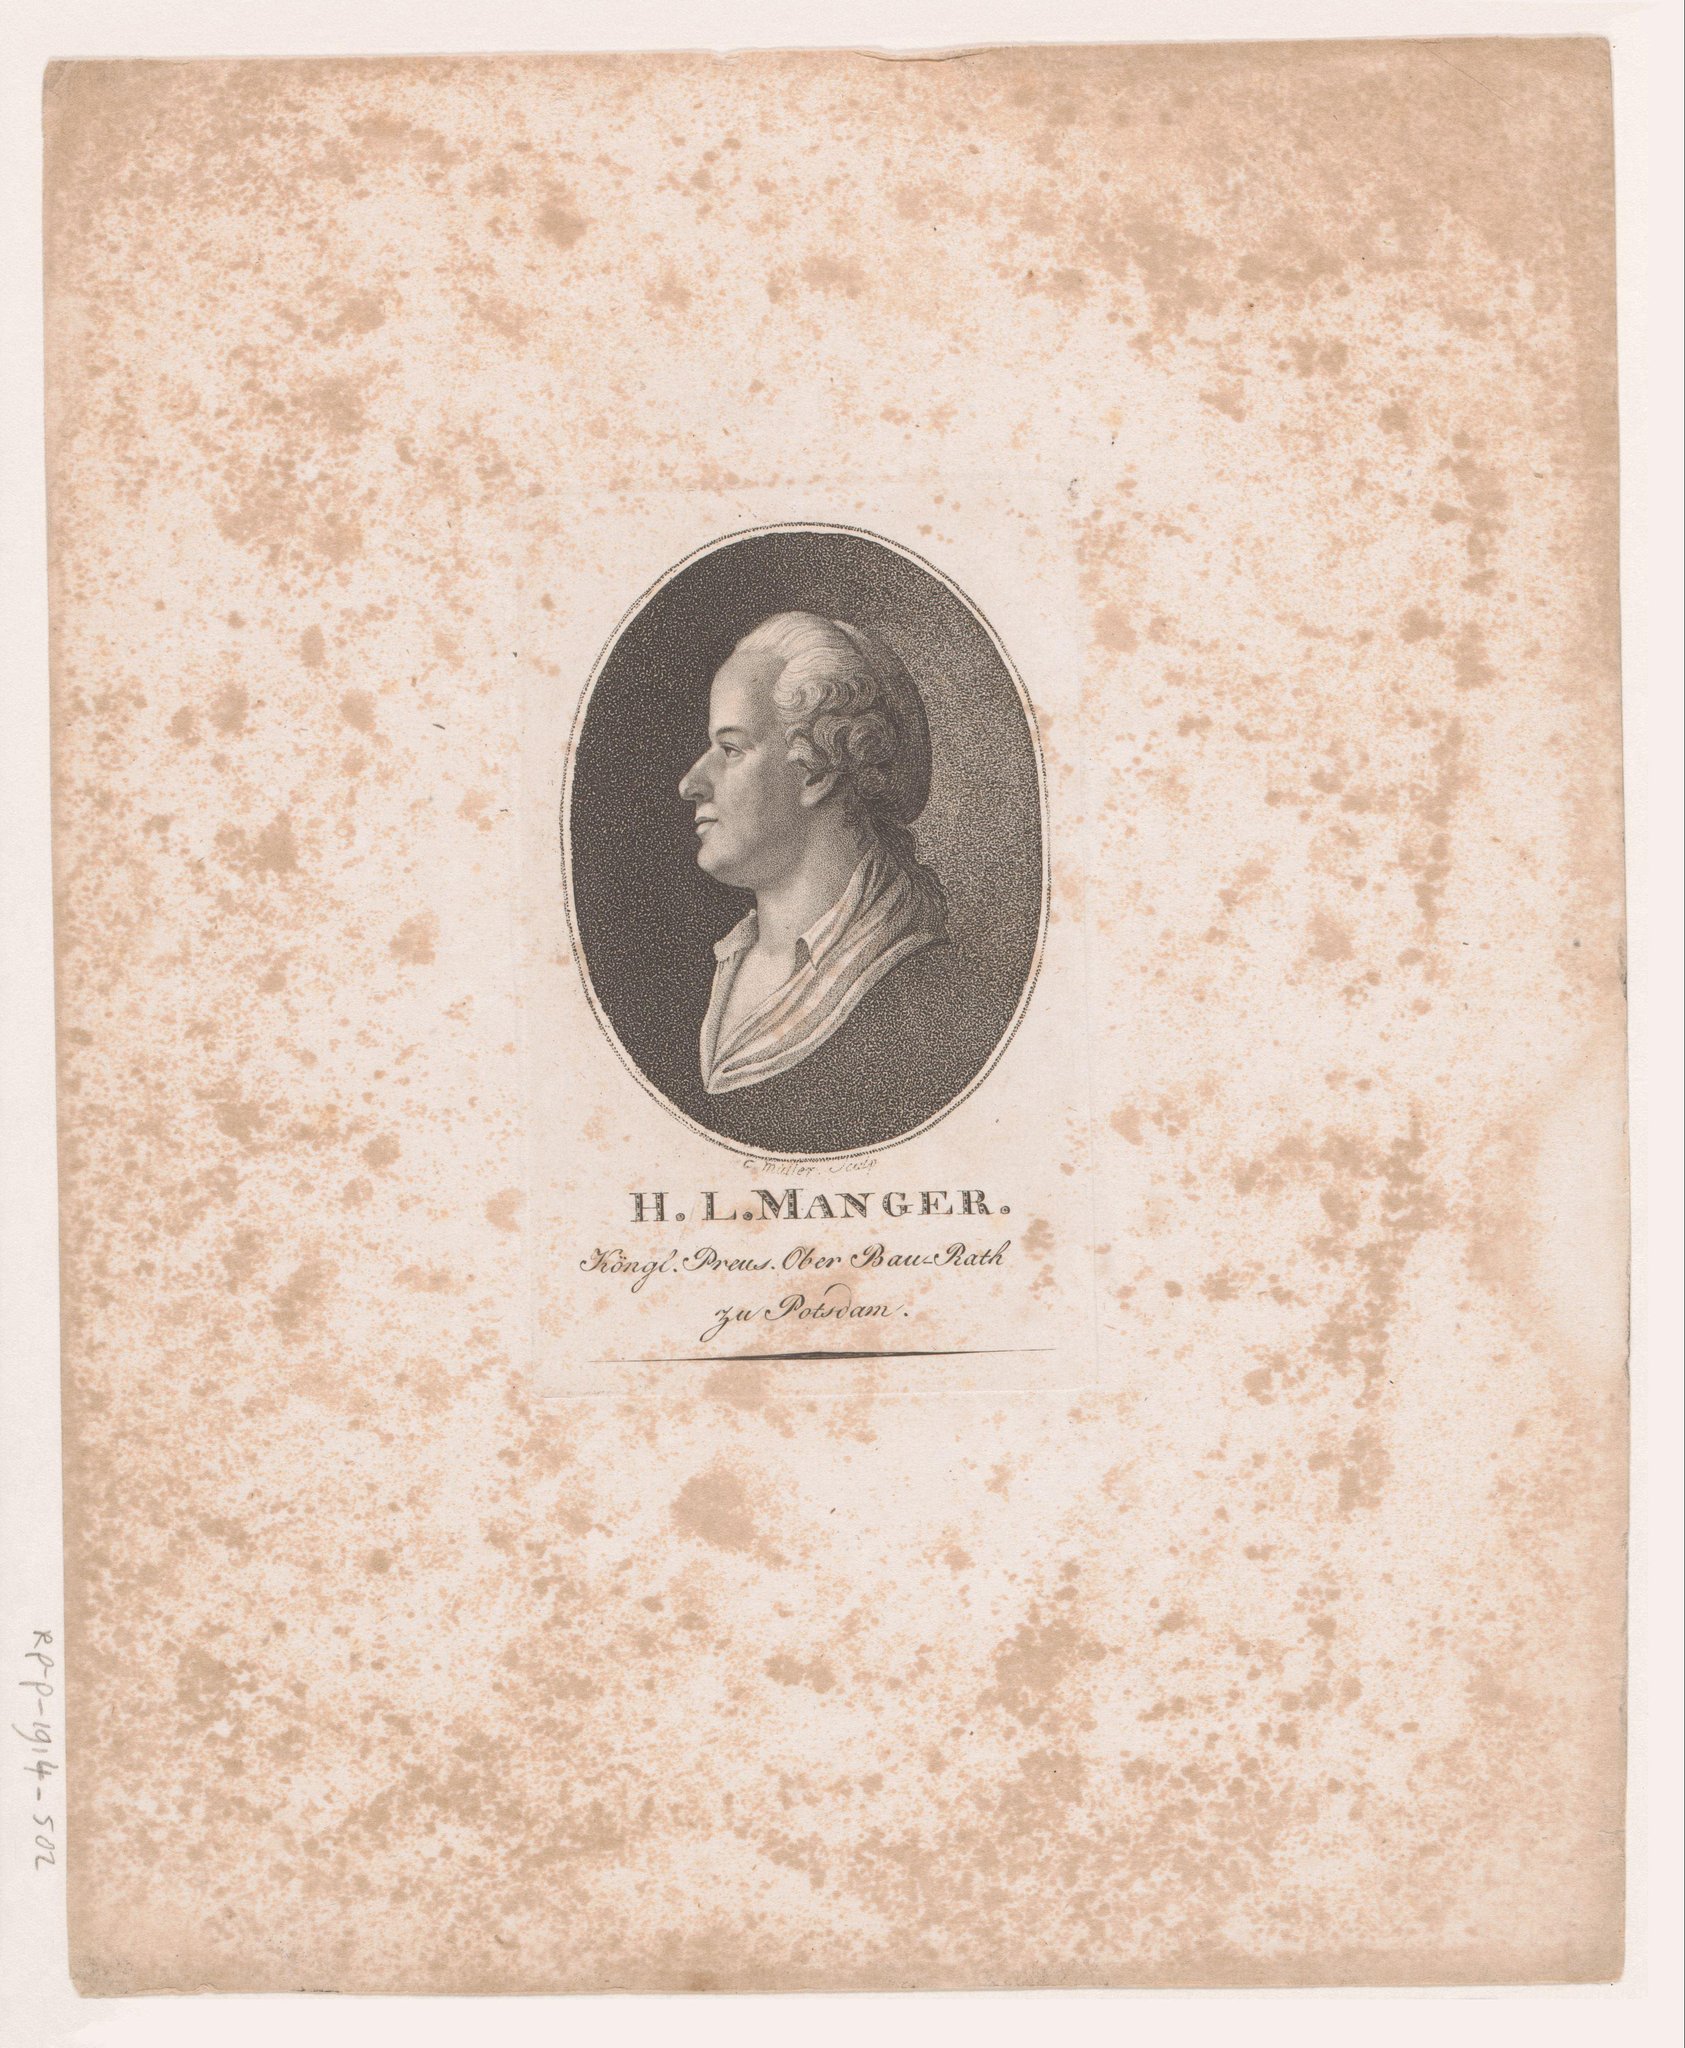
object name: print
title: Portret van Heinrich Ludewig Manger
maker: johann christian ernst müller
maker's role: draughtsman, print maker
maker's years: 1766-1824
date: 1776-1824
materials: paper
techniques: engraving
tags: portrait, self-portrait of architect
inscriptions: collector's mark: Lugt 2228